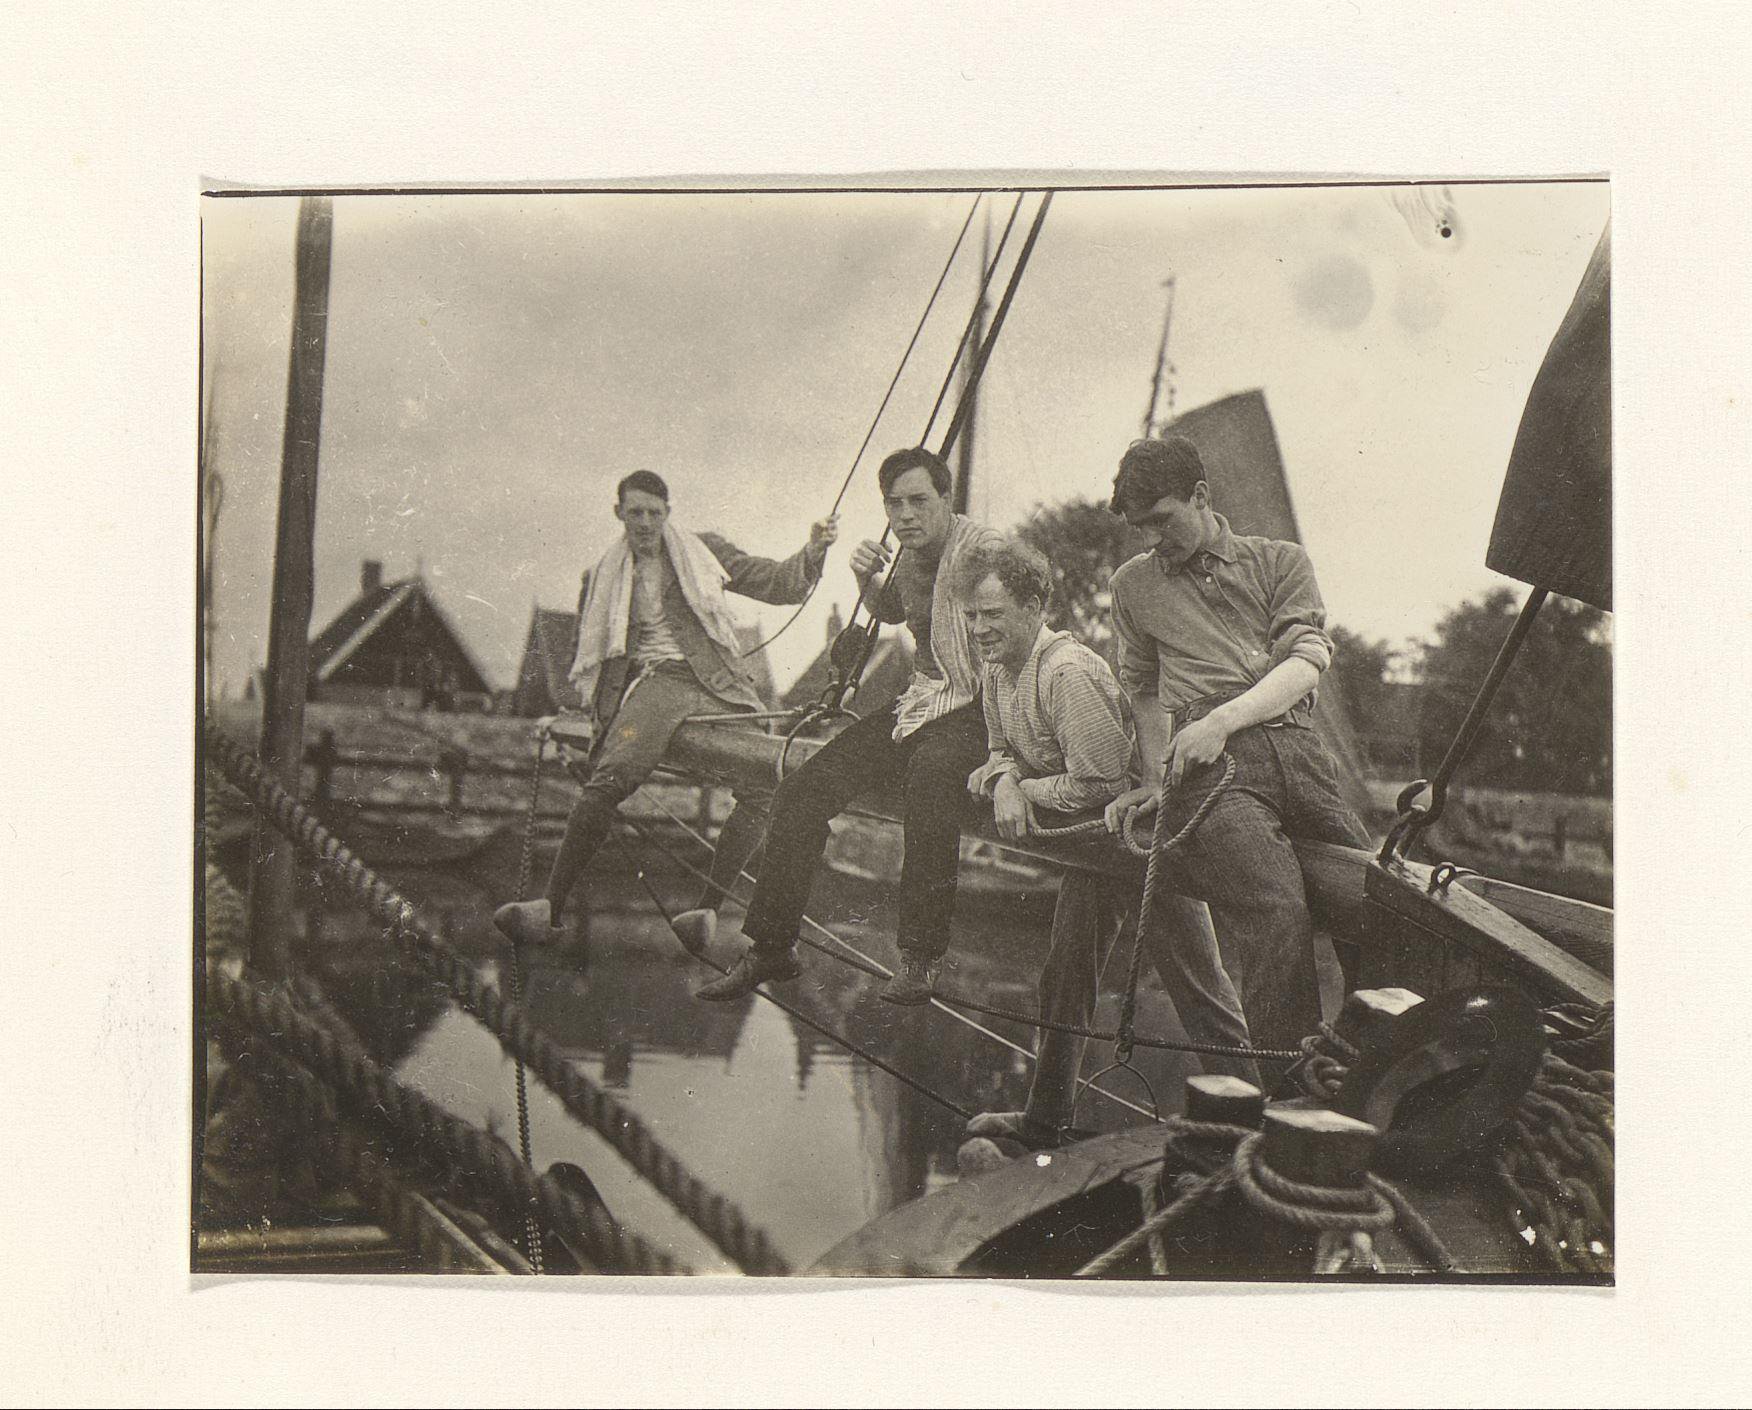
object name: album leaf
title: Mannen op een aangemeerde boot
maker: george hidderley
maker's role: fotograaf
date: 1900-1910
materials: paper, photographic support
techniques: gelatin silver print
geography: volendam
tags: sailing-ship, sailing-boat, adult man, historical persons